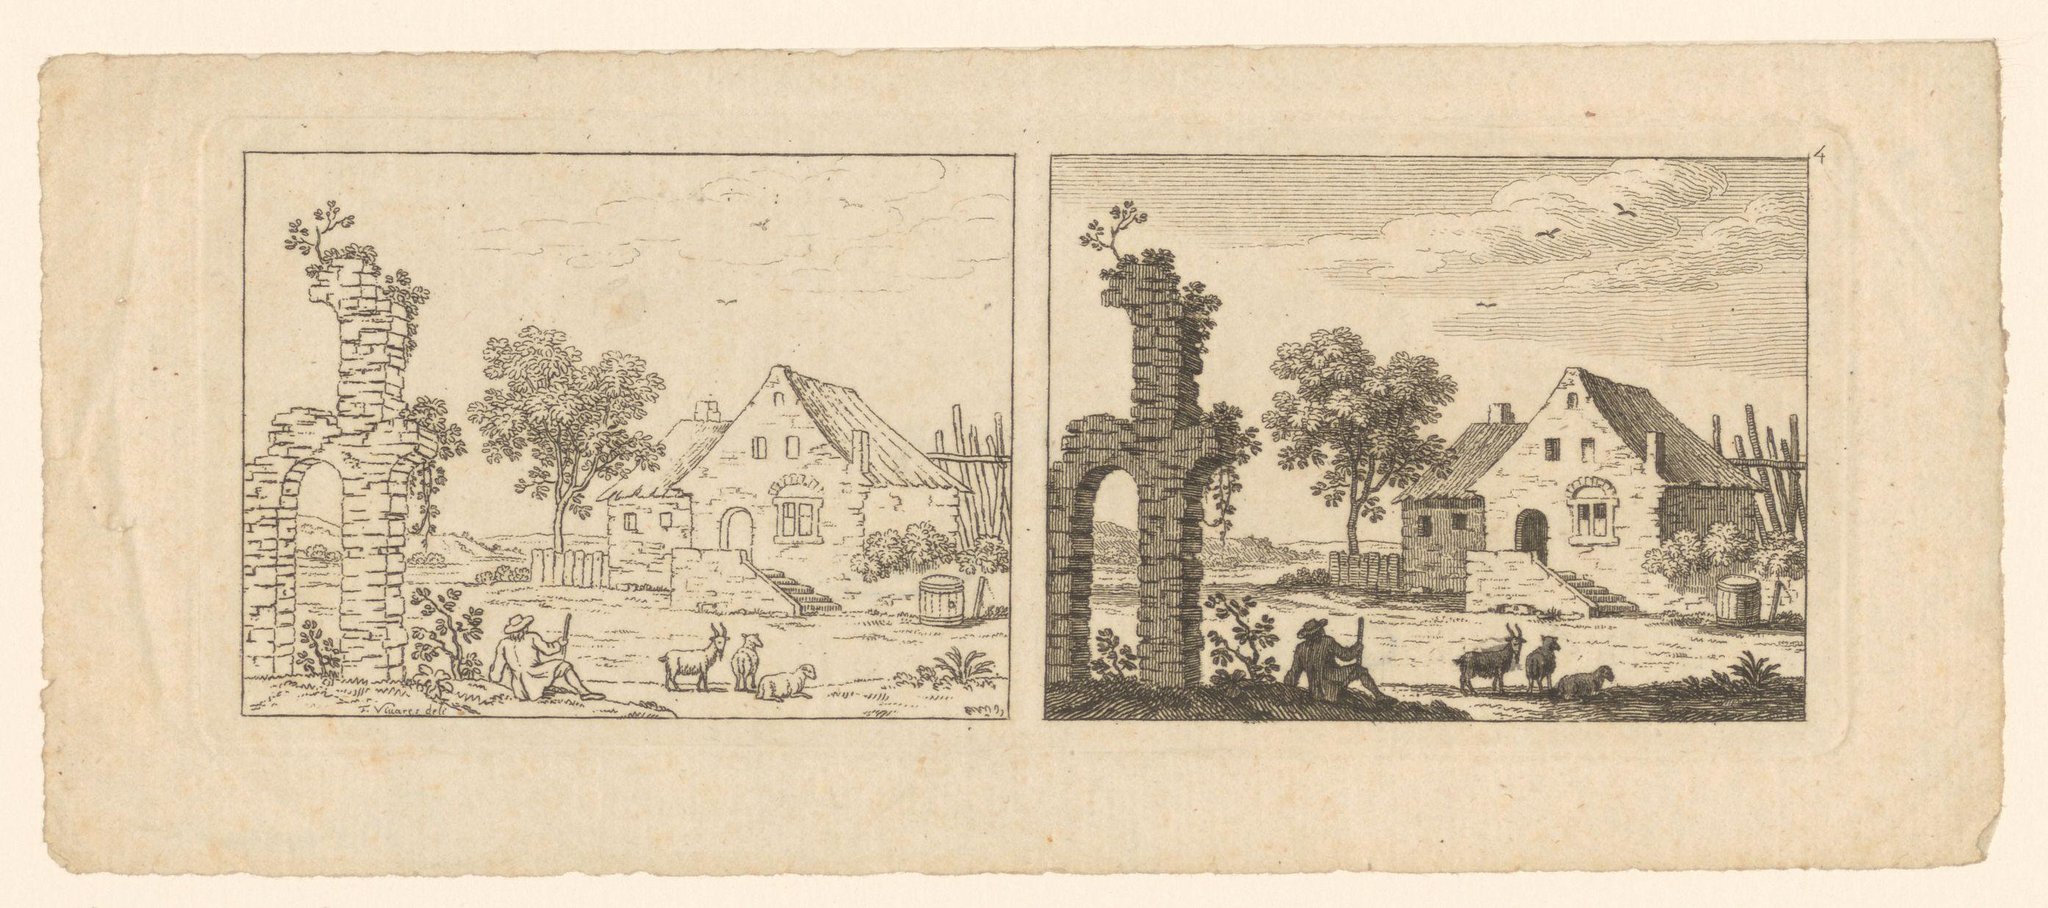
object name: print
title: Twee voorstellingen van hetzelfde landschap met boerderij en een ruïne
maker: françois vivares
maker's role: print maker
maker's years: 1709-1780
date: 1719-1780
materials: paper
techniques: etching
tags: landscape with ruins (+ city(-scape) with figures, staffage), farm or solitary house in landscape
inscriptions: collector's mark: Lugt 2228, collector's mark: Lugt 2228